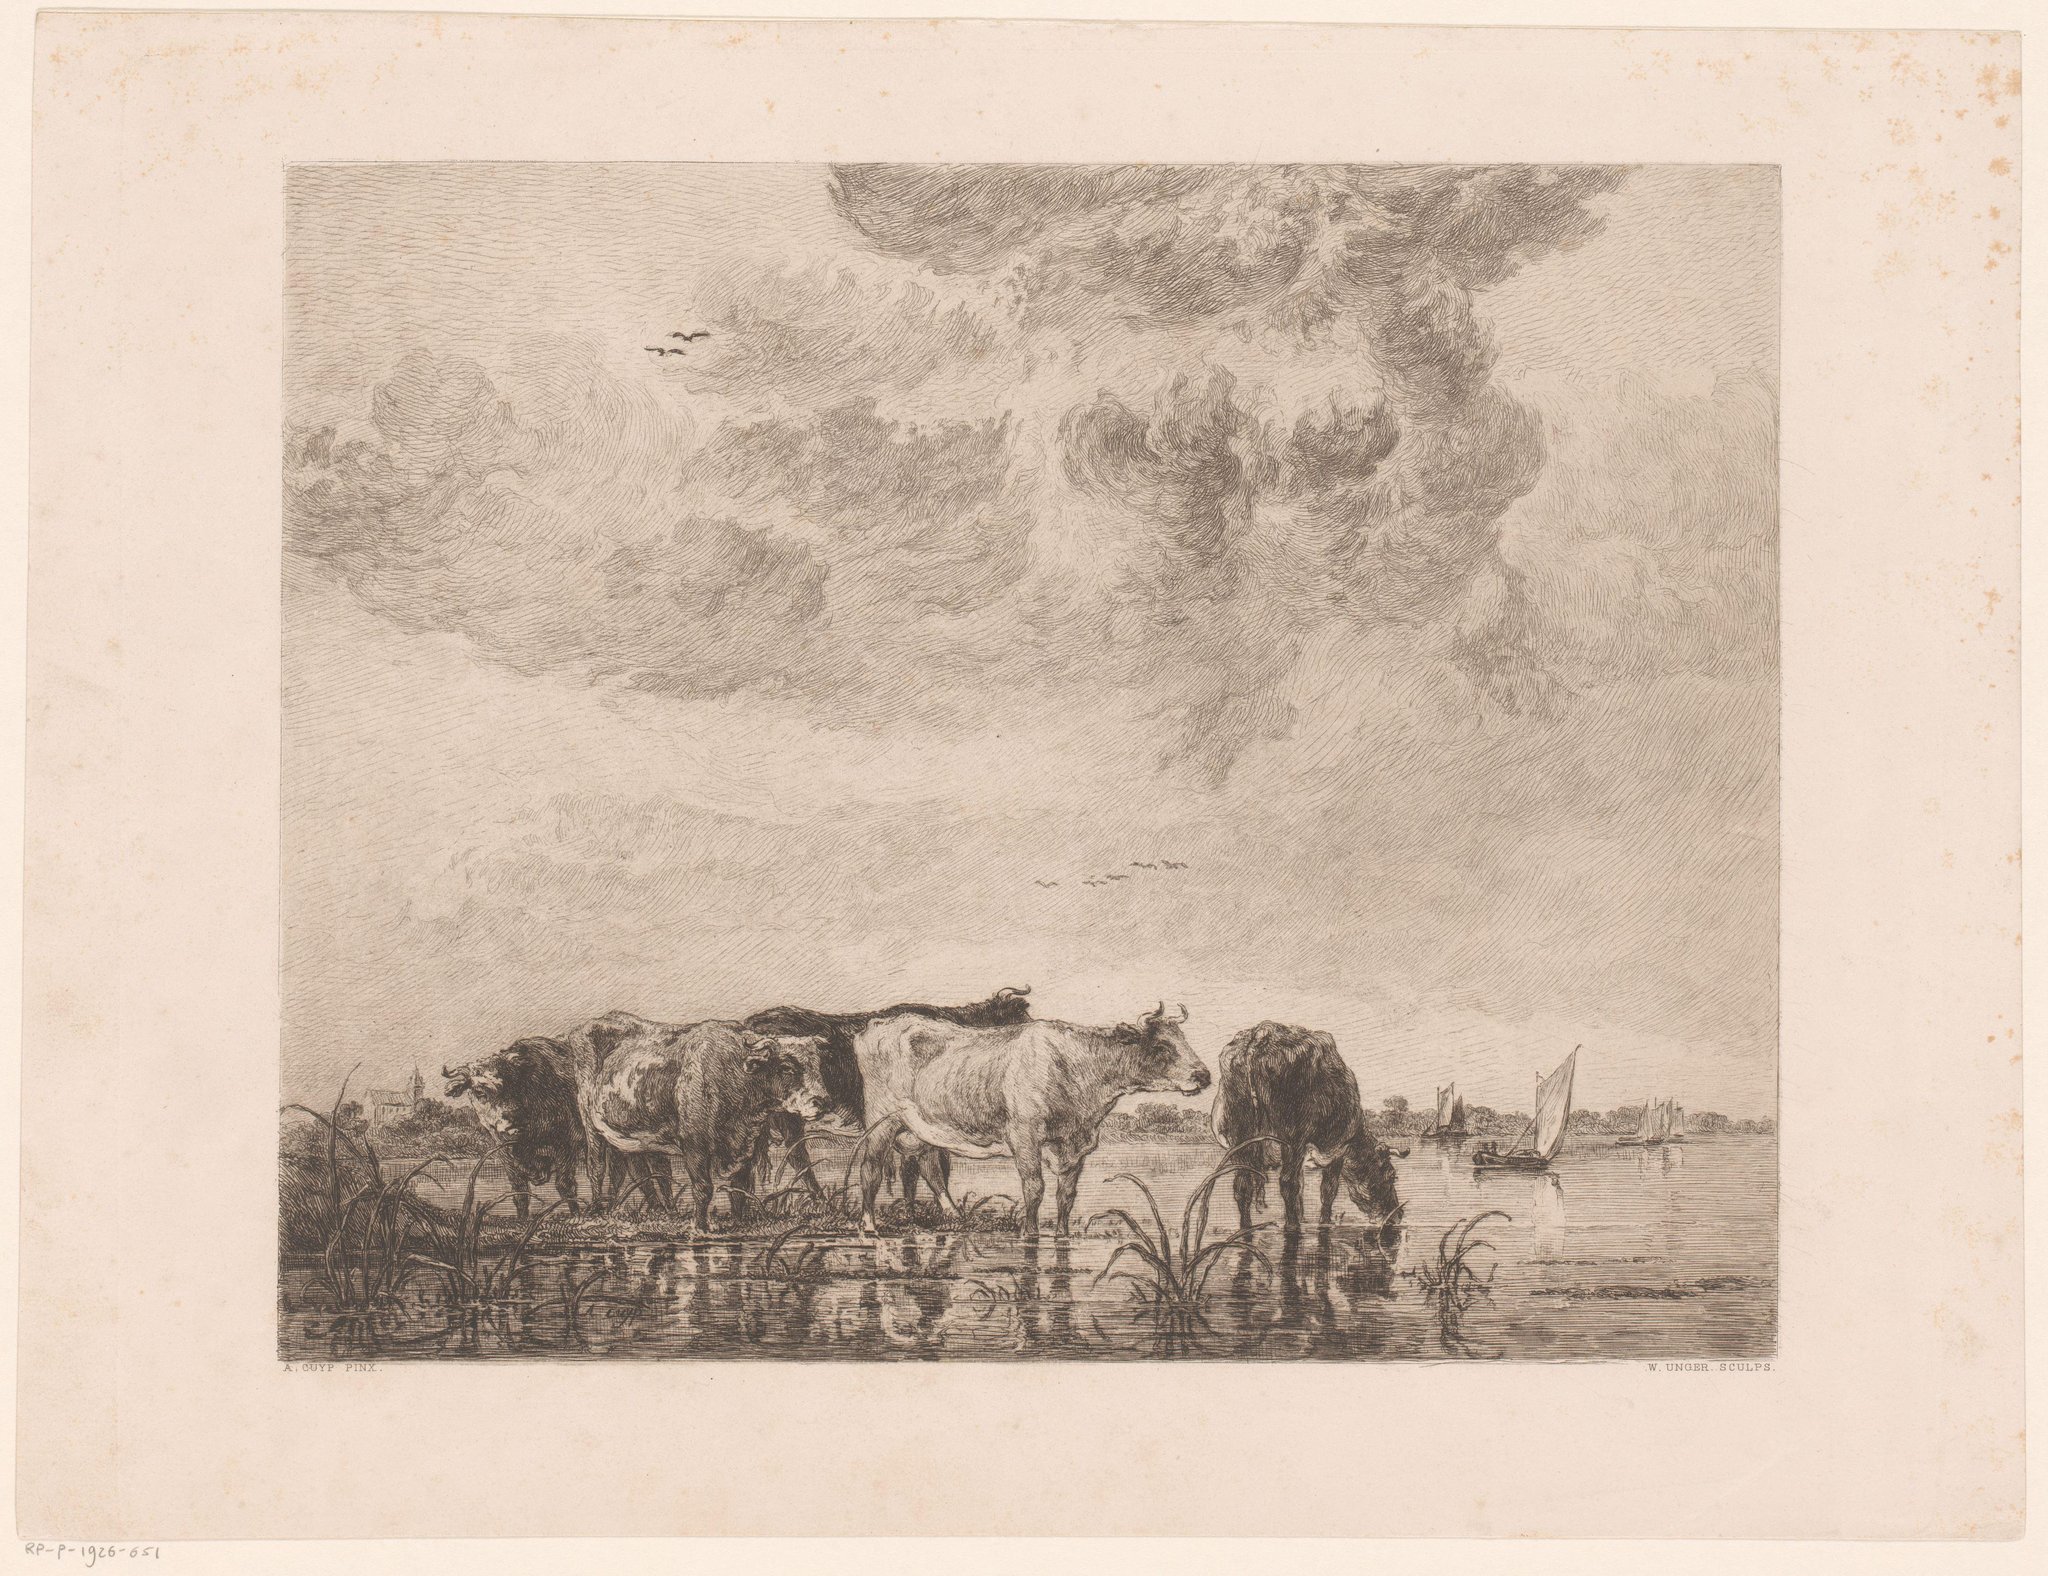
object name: print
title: Landschap met waterende koeien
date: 1847-1926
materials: paper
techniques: etching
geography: germany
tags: sailing-ship, sailing-boat, giving water, feeding (cattle), bovine cattle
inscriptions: collector's mark: Lugt 2228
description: Een tekening van koeien in potlood op verso.